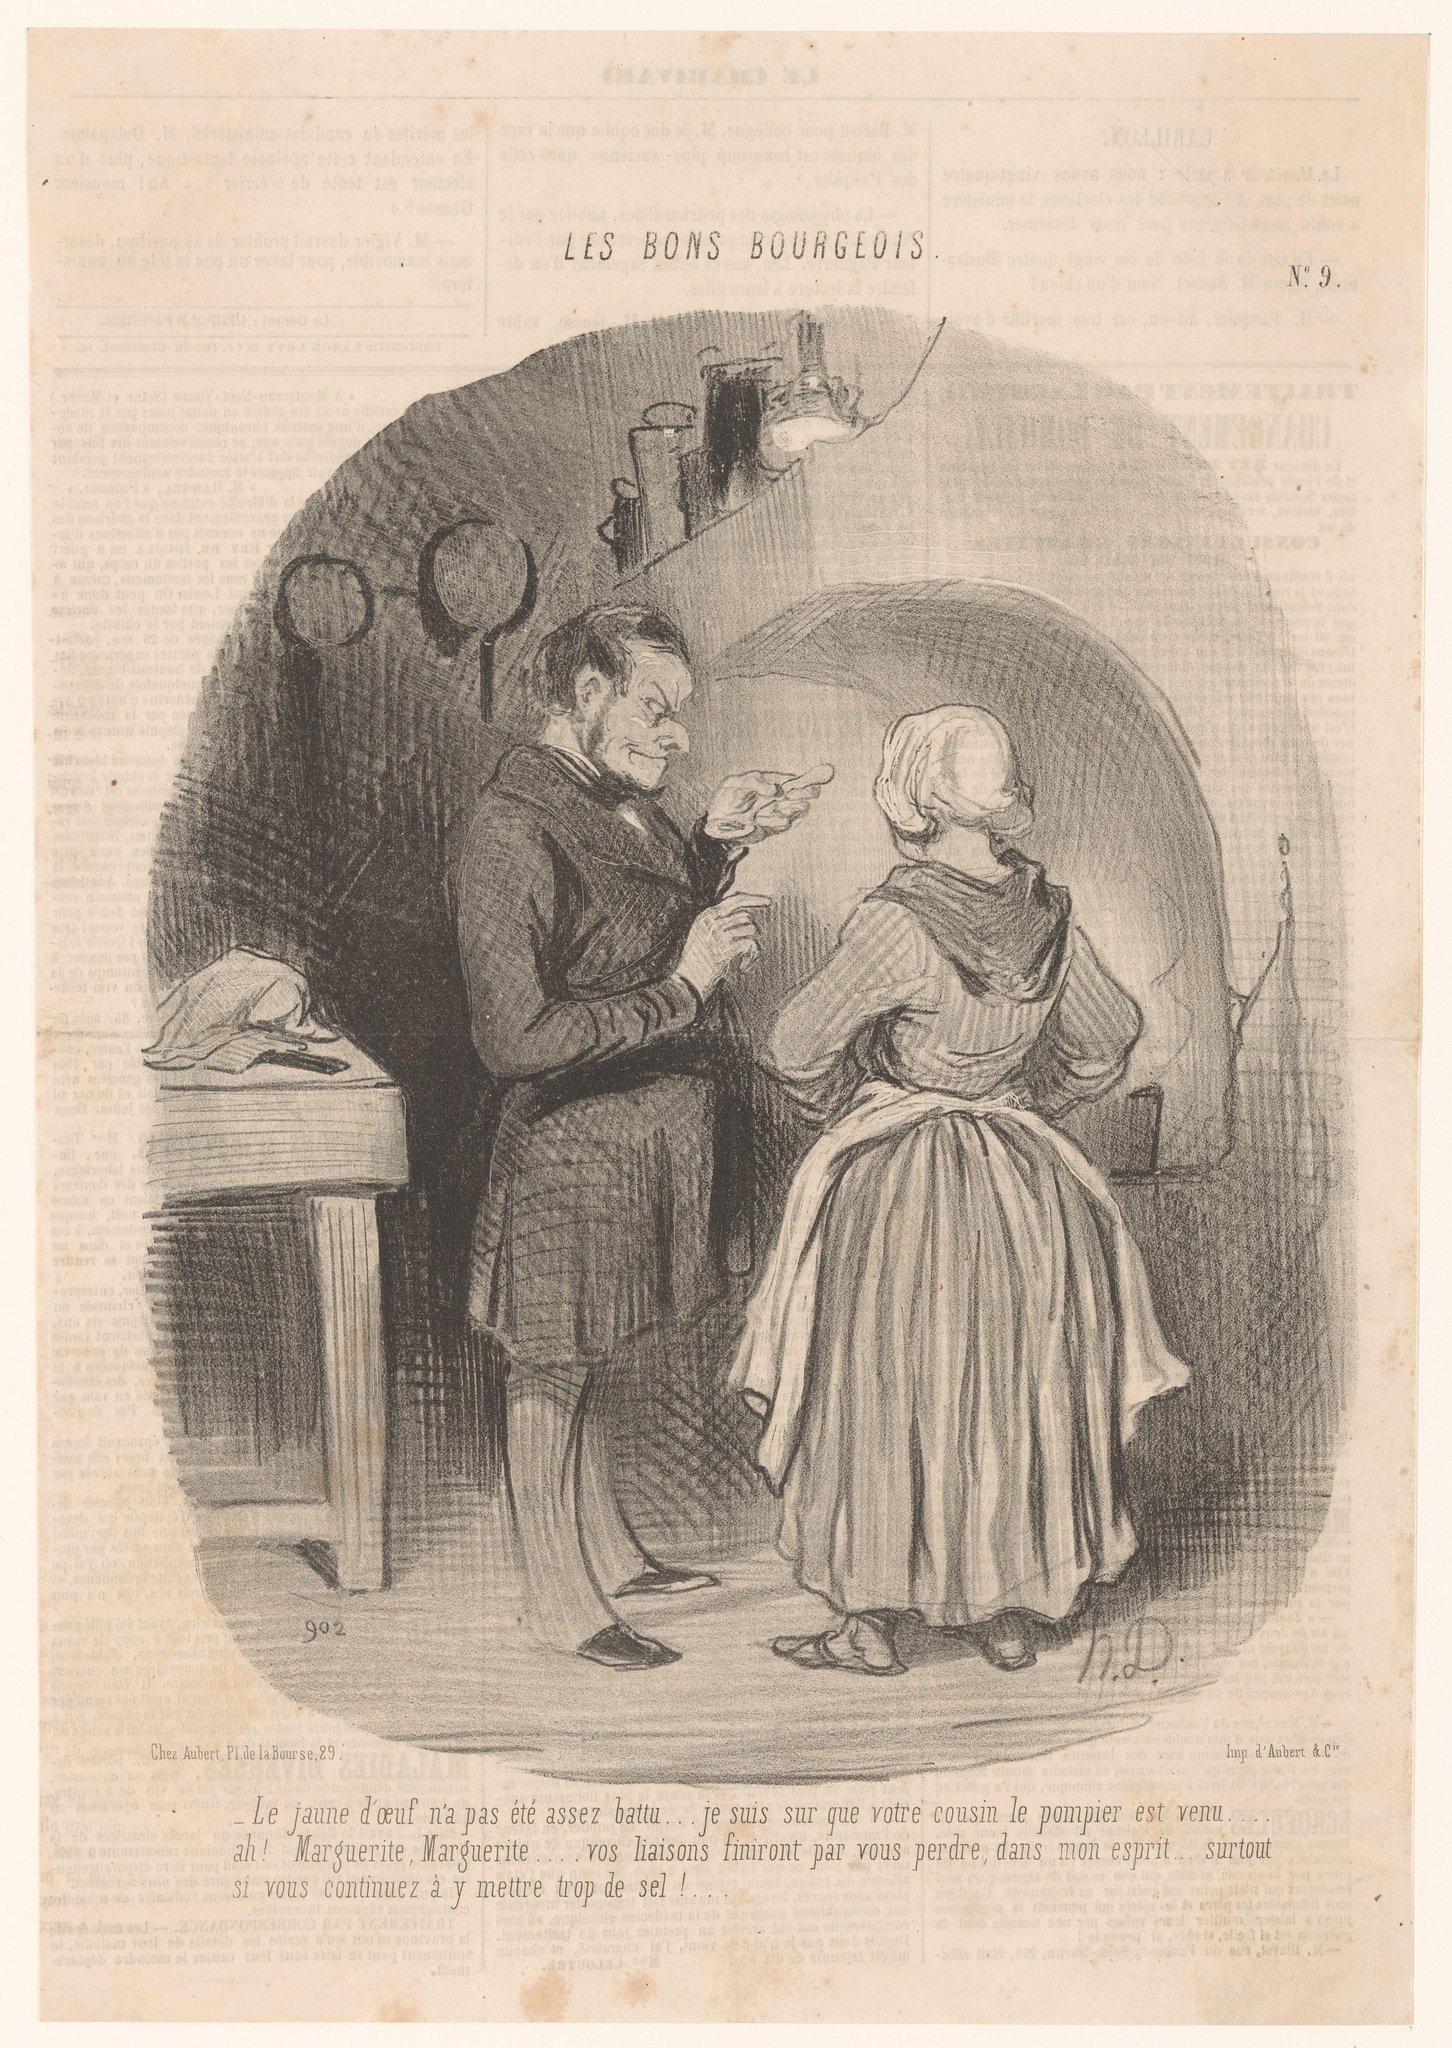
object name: cartoon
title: Le jaune d'oeuf n'a pas été assez battu (...)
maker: honoré daumier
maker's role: draughtsman, painter, print maker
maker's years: 1808-1879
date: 1846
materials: paper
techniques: lithograph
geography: paris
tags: caricatures (human types), eggs, egg-dishes, kitchen-maid, kitchen servant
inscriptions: collector's mark: Lugt 2228a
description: Prent gebruikt voor: Le Charivari, 24-07-1846.